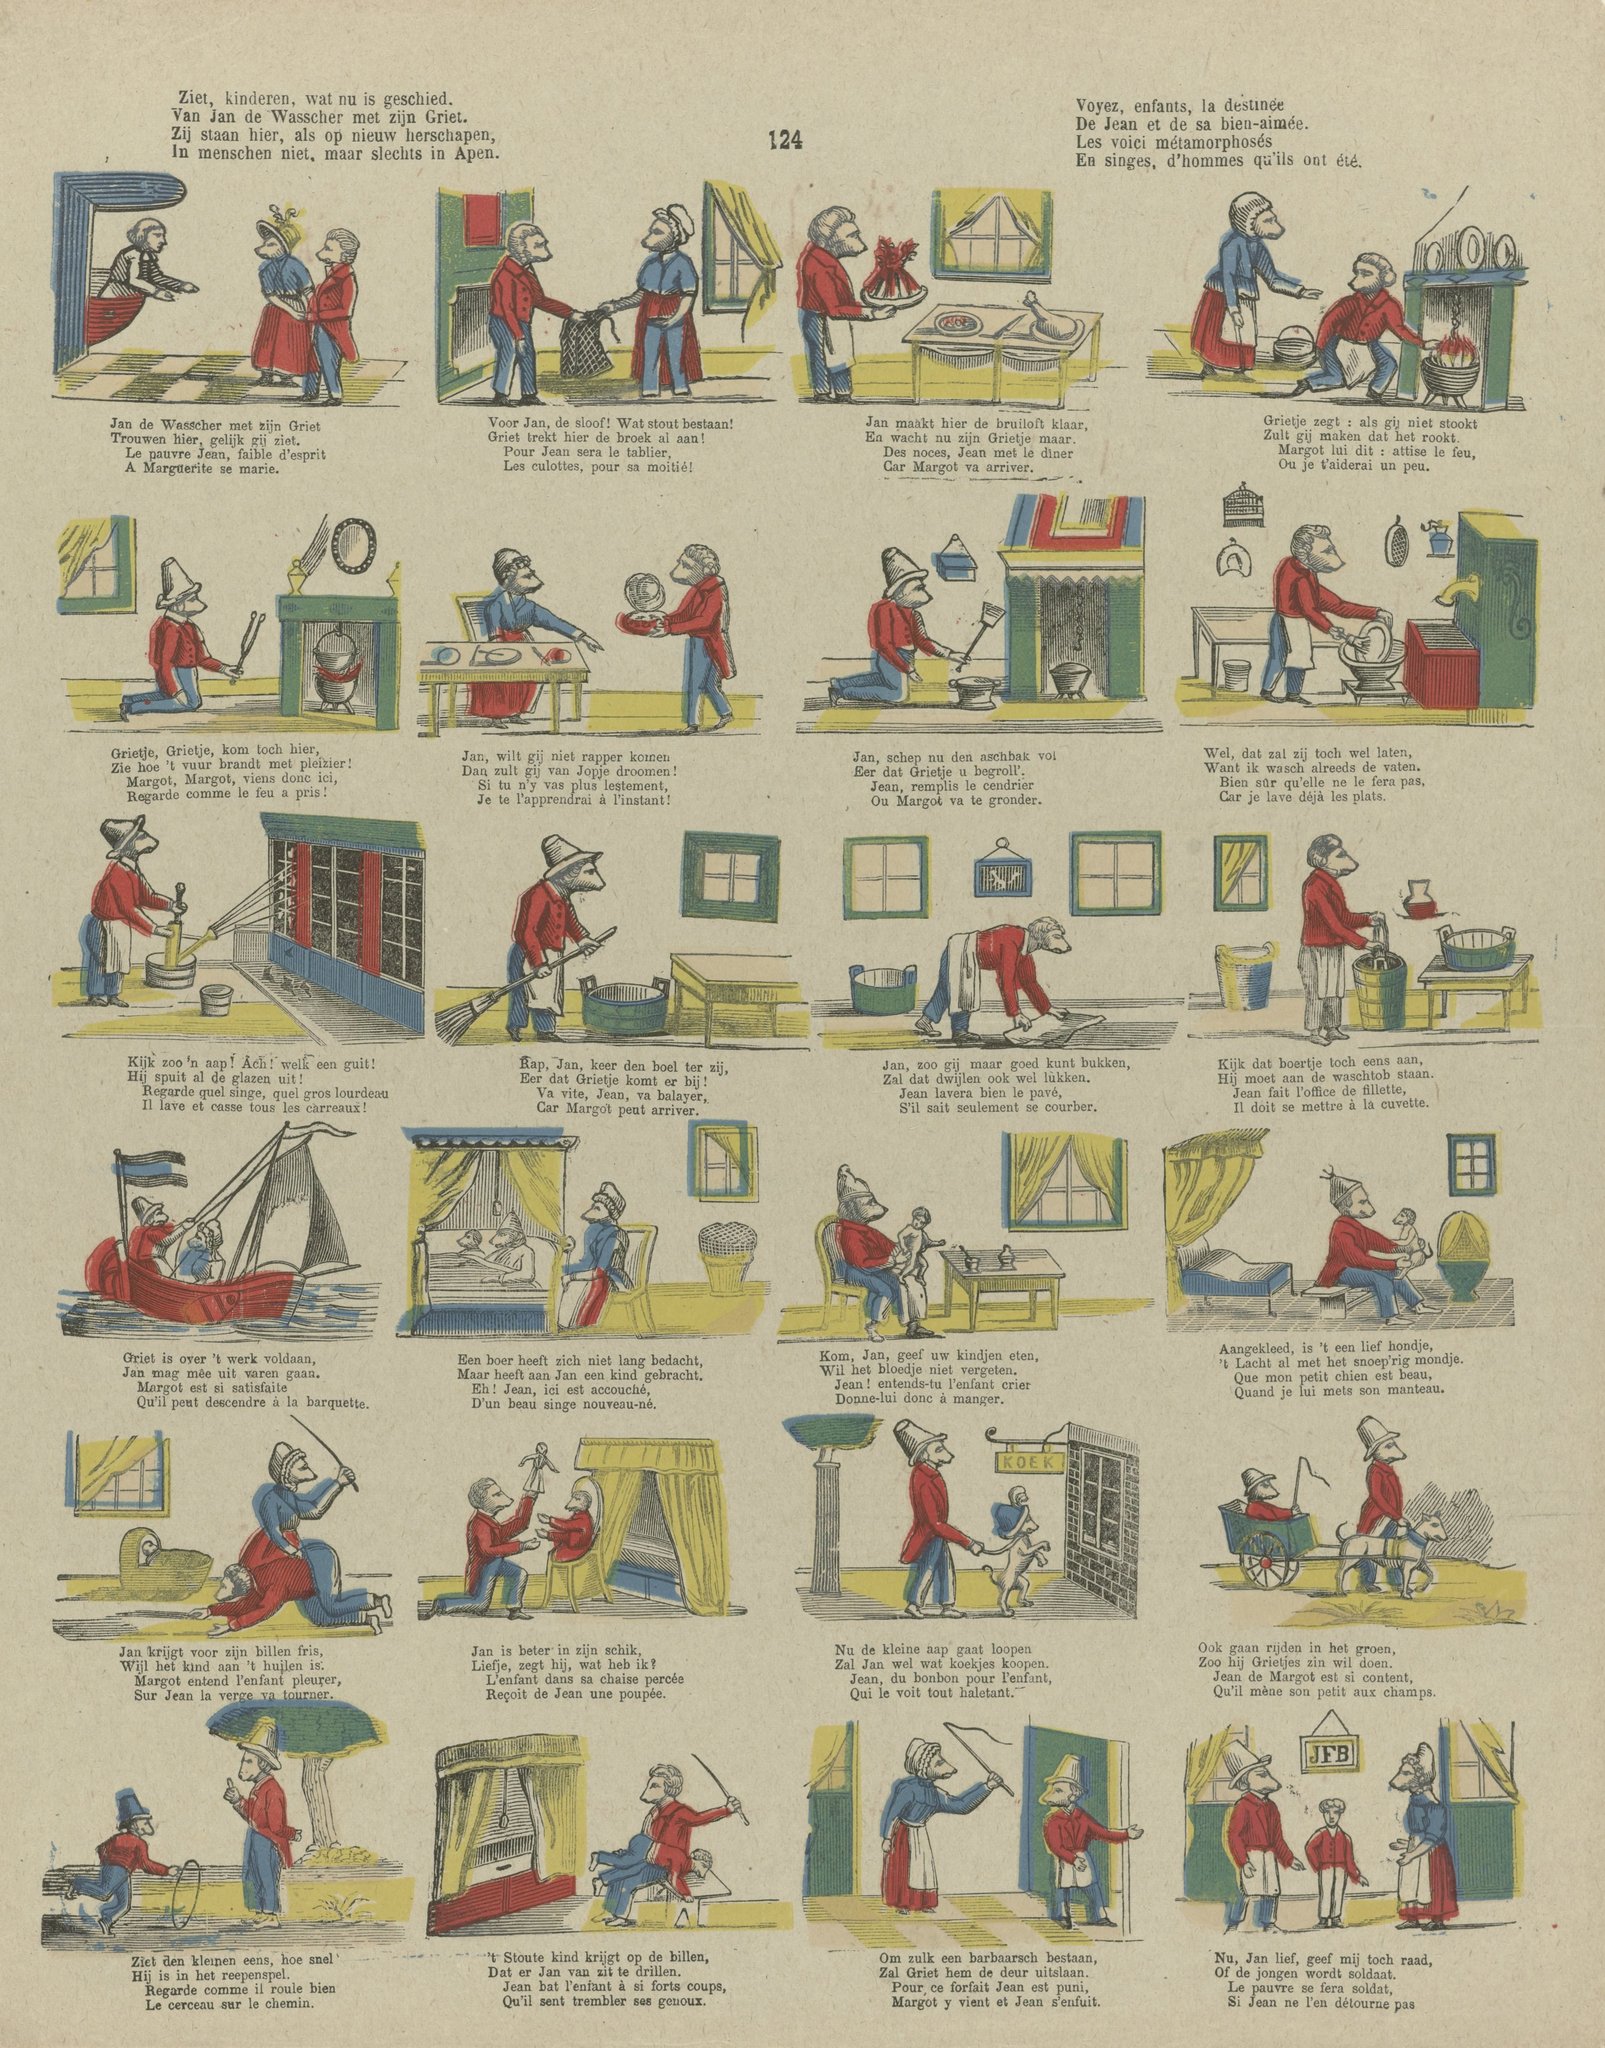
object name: print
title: Ziet, kinderen, wat nu is geschied, / Van de Wasscher met zijn Griet [(...)]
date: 1800-1833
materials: paper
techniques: lithograph, letterpress printing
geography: turnhout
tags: hen-pecked husband, 'betty', 'molly' (man who engages in women's work), monkeys, apes, animals acting as human beings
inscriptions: collector's mark: Lugt 2760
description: Blad met 24 voorstellingen uit het leven van Jan de Wasser, een man die van zijn vrouw Griet, die de broek aan heeft, al het huishoudelijk werk moet doen. Uitgebeeld met apen in plaats van mensen. Onder elke voorstelling een tweeregelig vers in het Nederlands en in het Frans. Genummerd midden boven: 124.